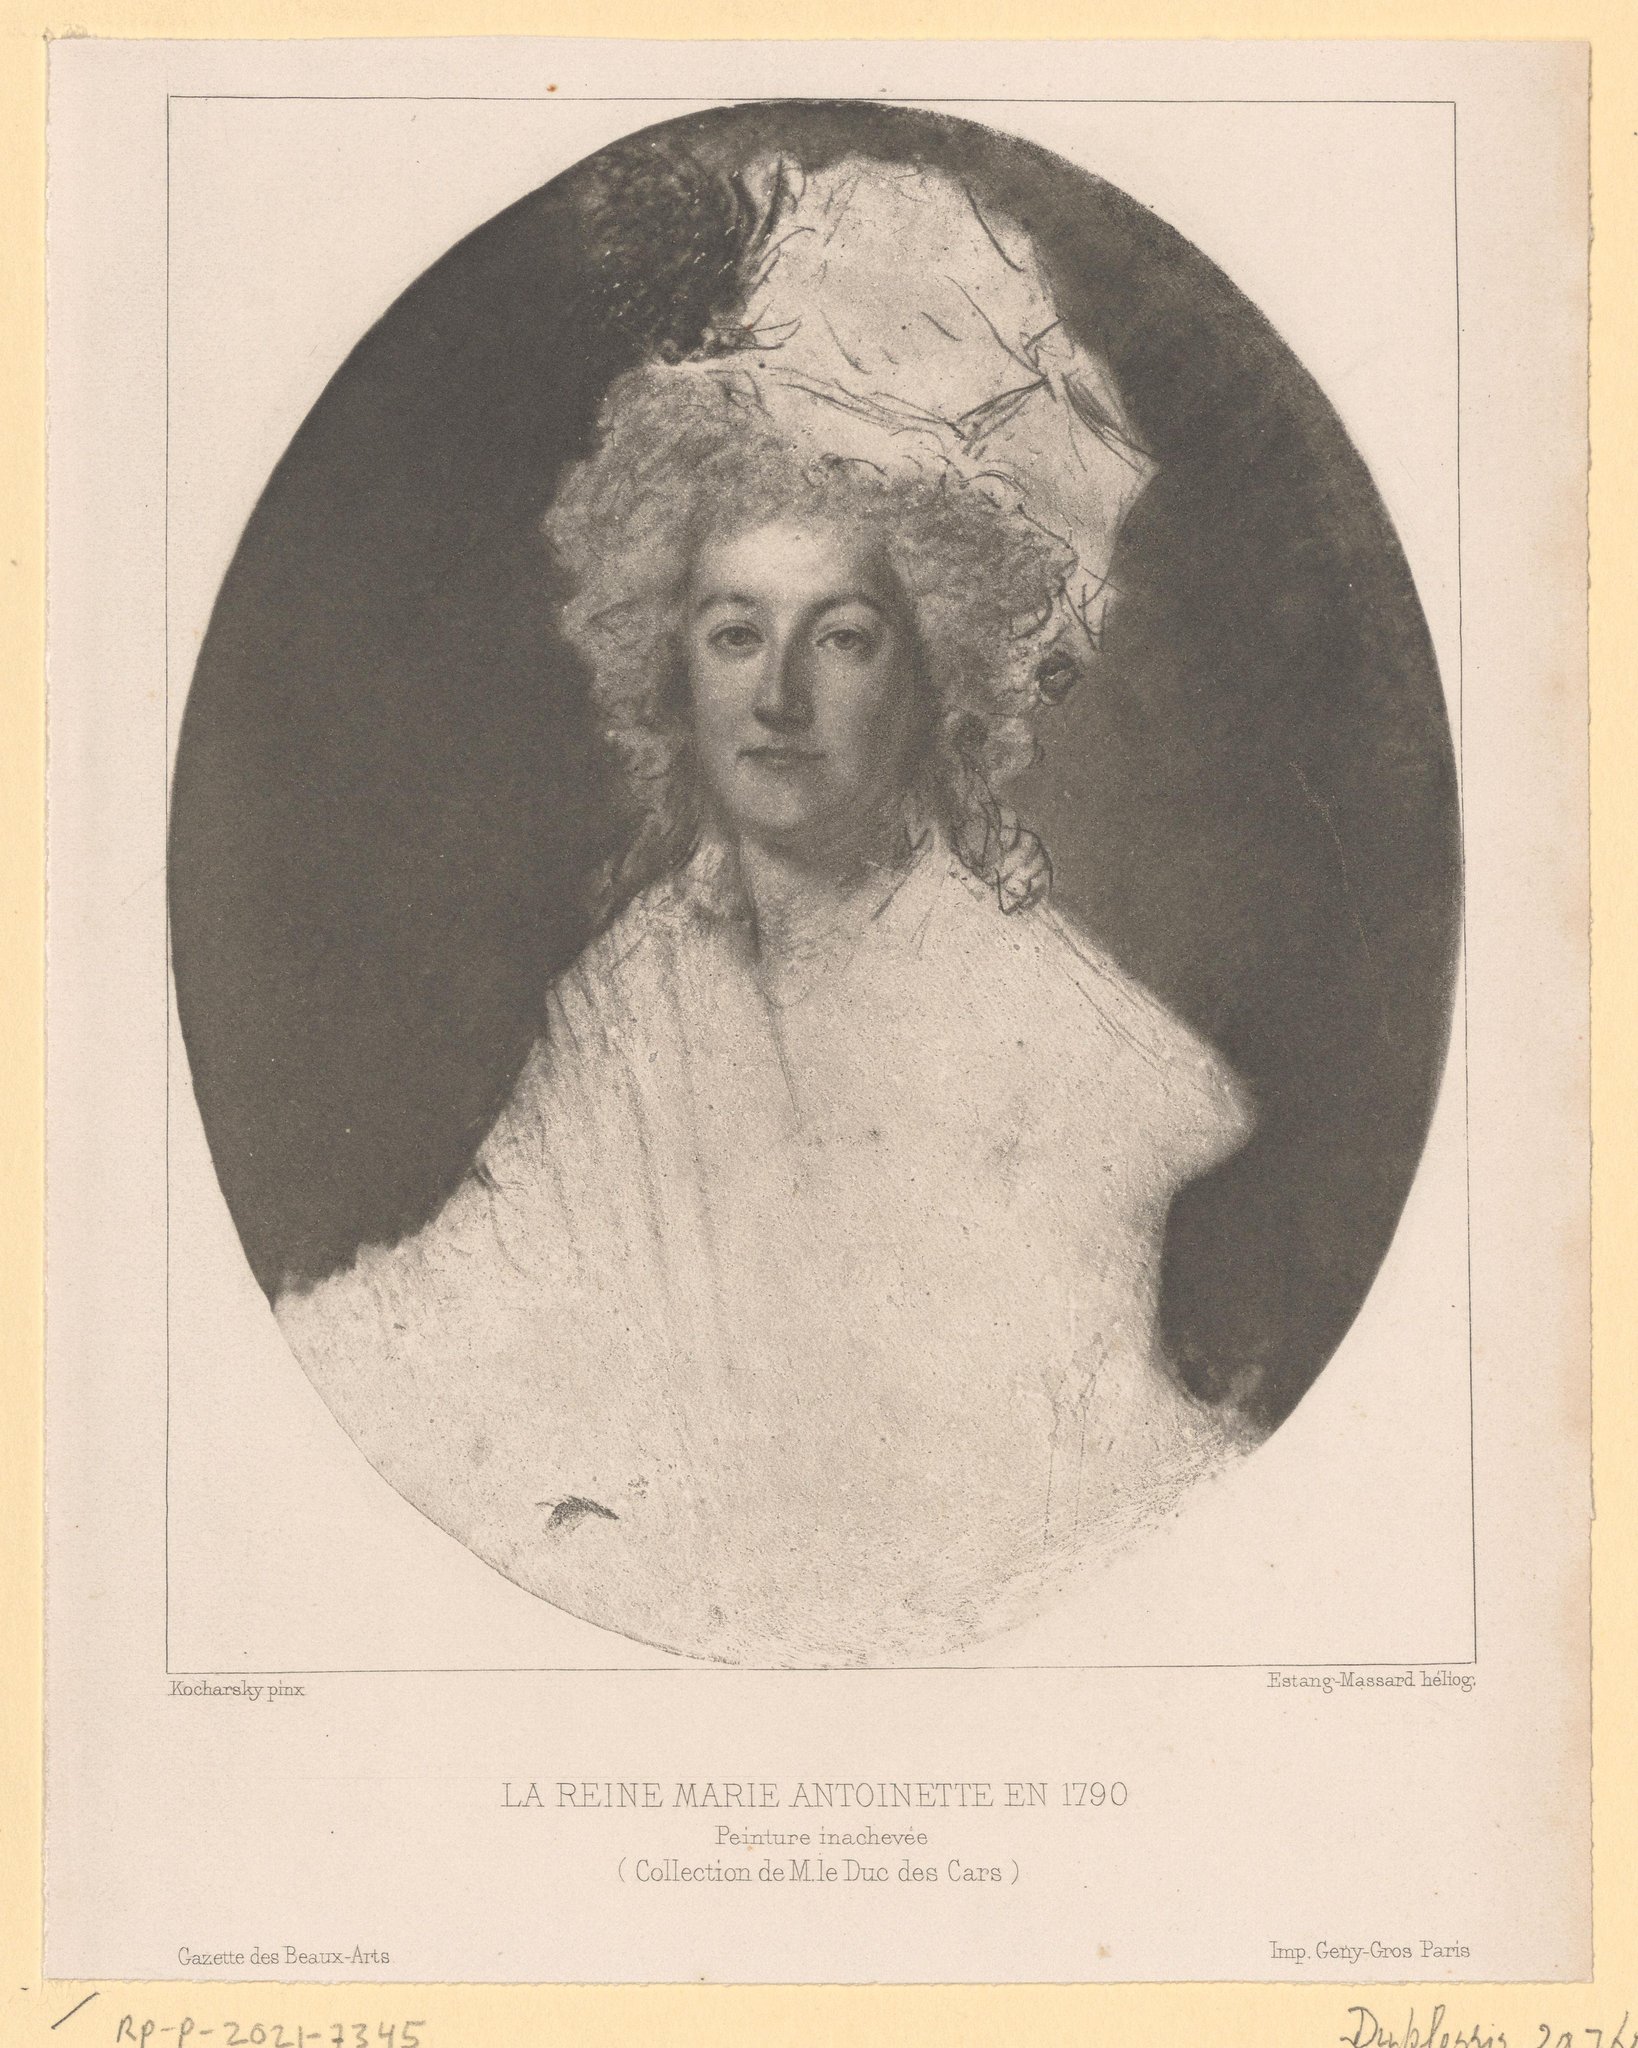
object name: photomechanical print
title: Portret van Marie Antoinette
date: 1894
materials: paper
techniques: photoaquatint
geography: france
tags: vienna, paris, marie antoinette, historical persons - bb - woman, queen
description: Prent waarschijnlijk uit: Gazette des beaux-arts, 1894.